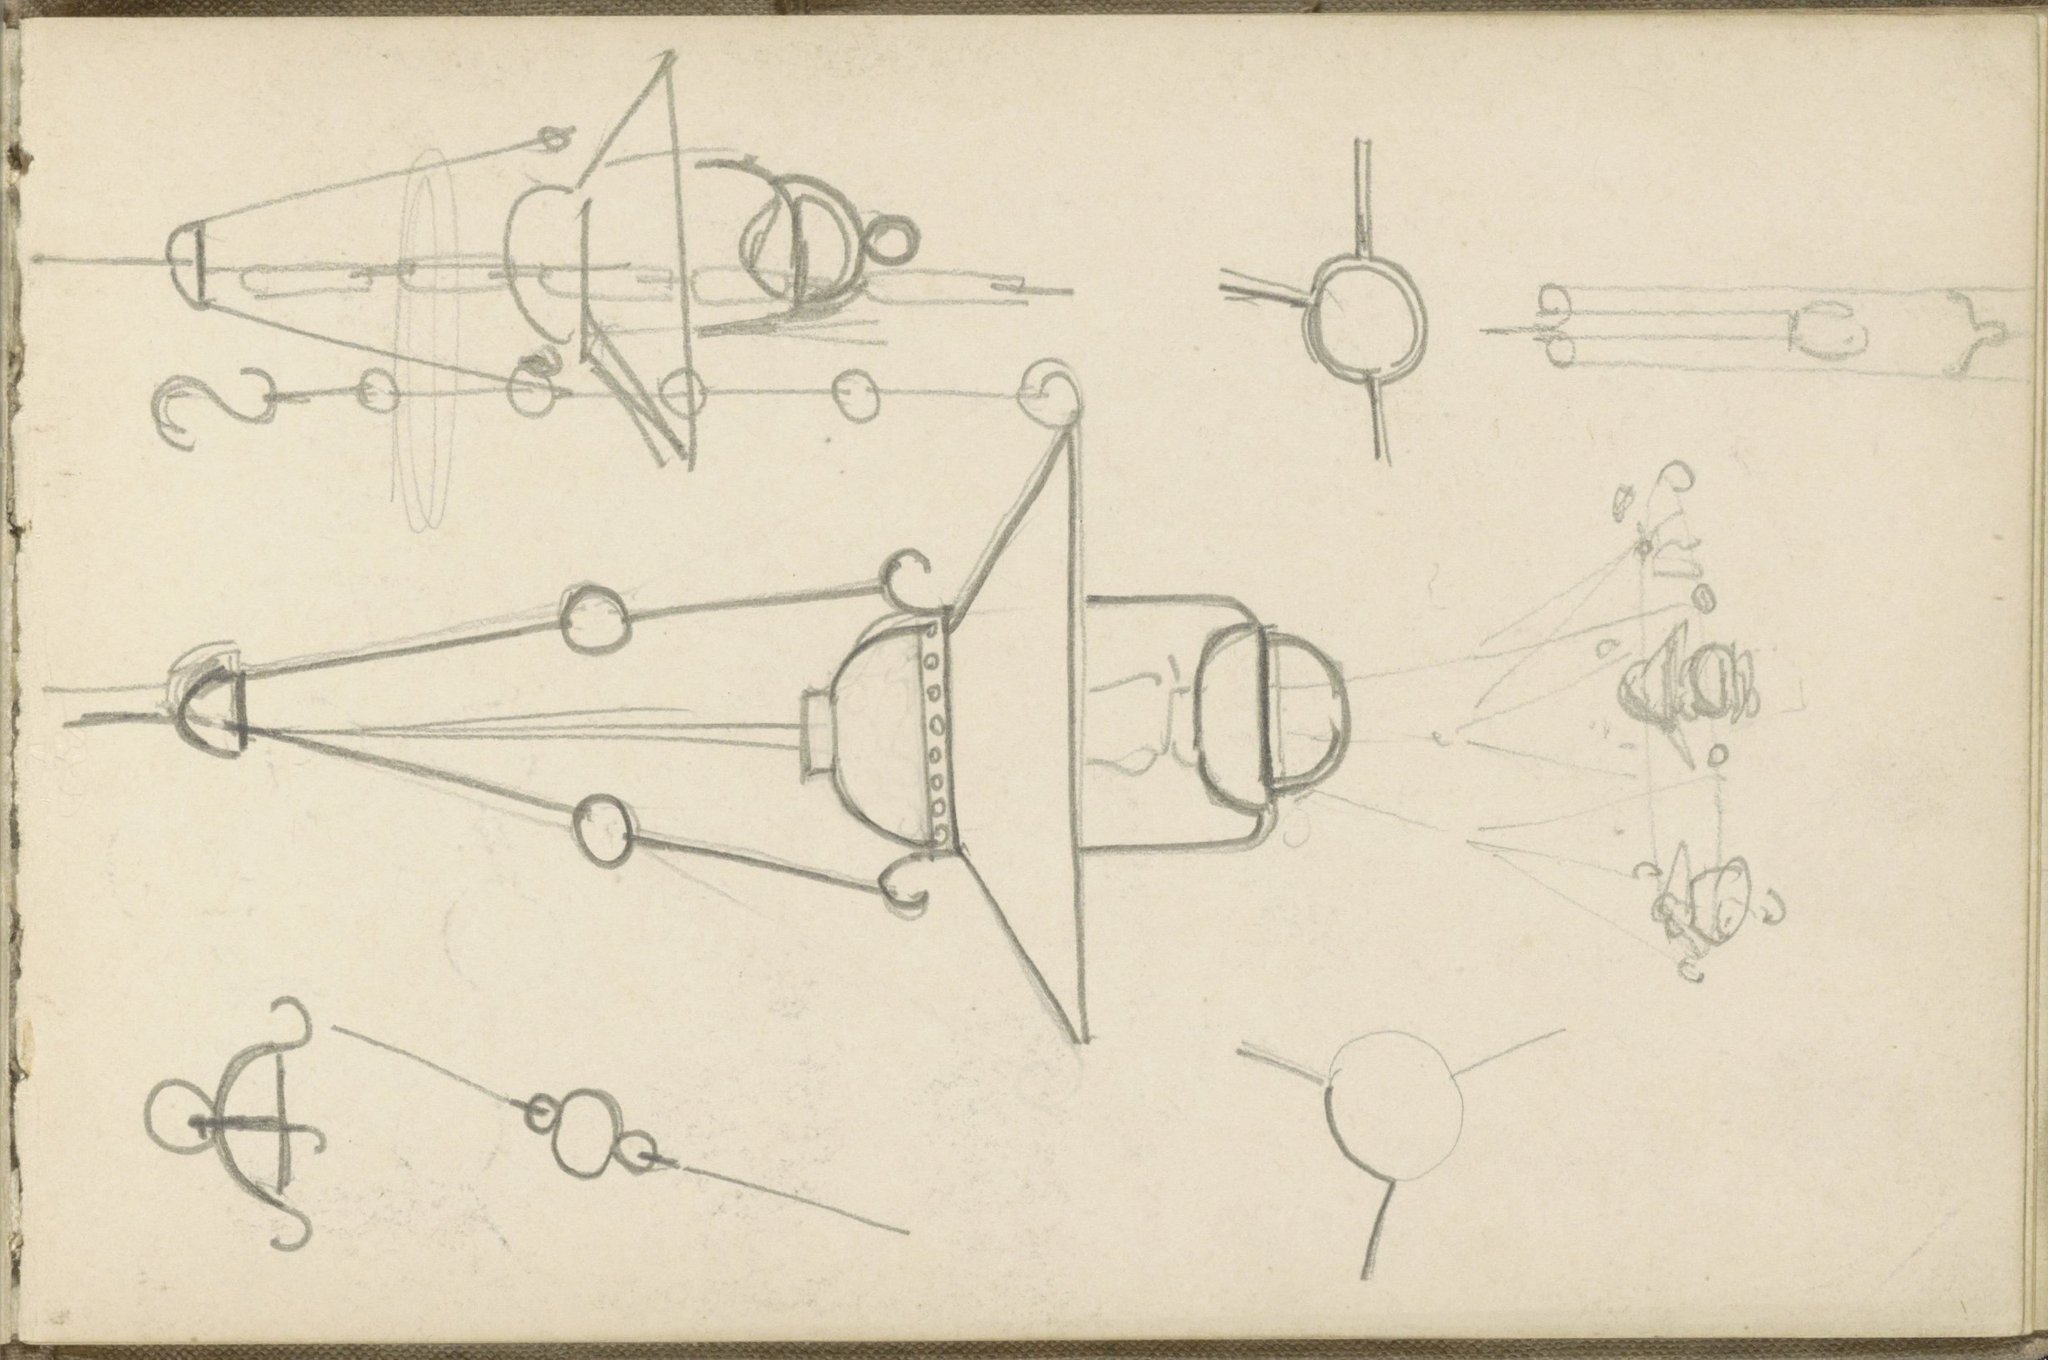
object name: sketchbook leaf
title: Ontwerpen voor elektrische hanglampen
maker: carel adolph lion cachet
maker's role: draughtsman, print maker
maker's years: 1864-1945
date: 1905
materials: paper, pencil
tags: electric lamp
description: Blad 14 recto uit een schetsboek met 27 bladen.